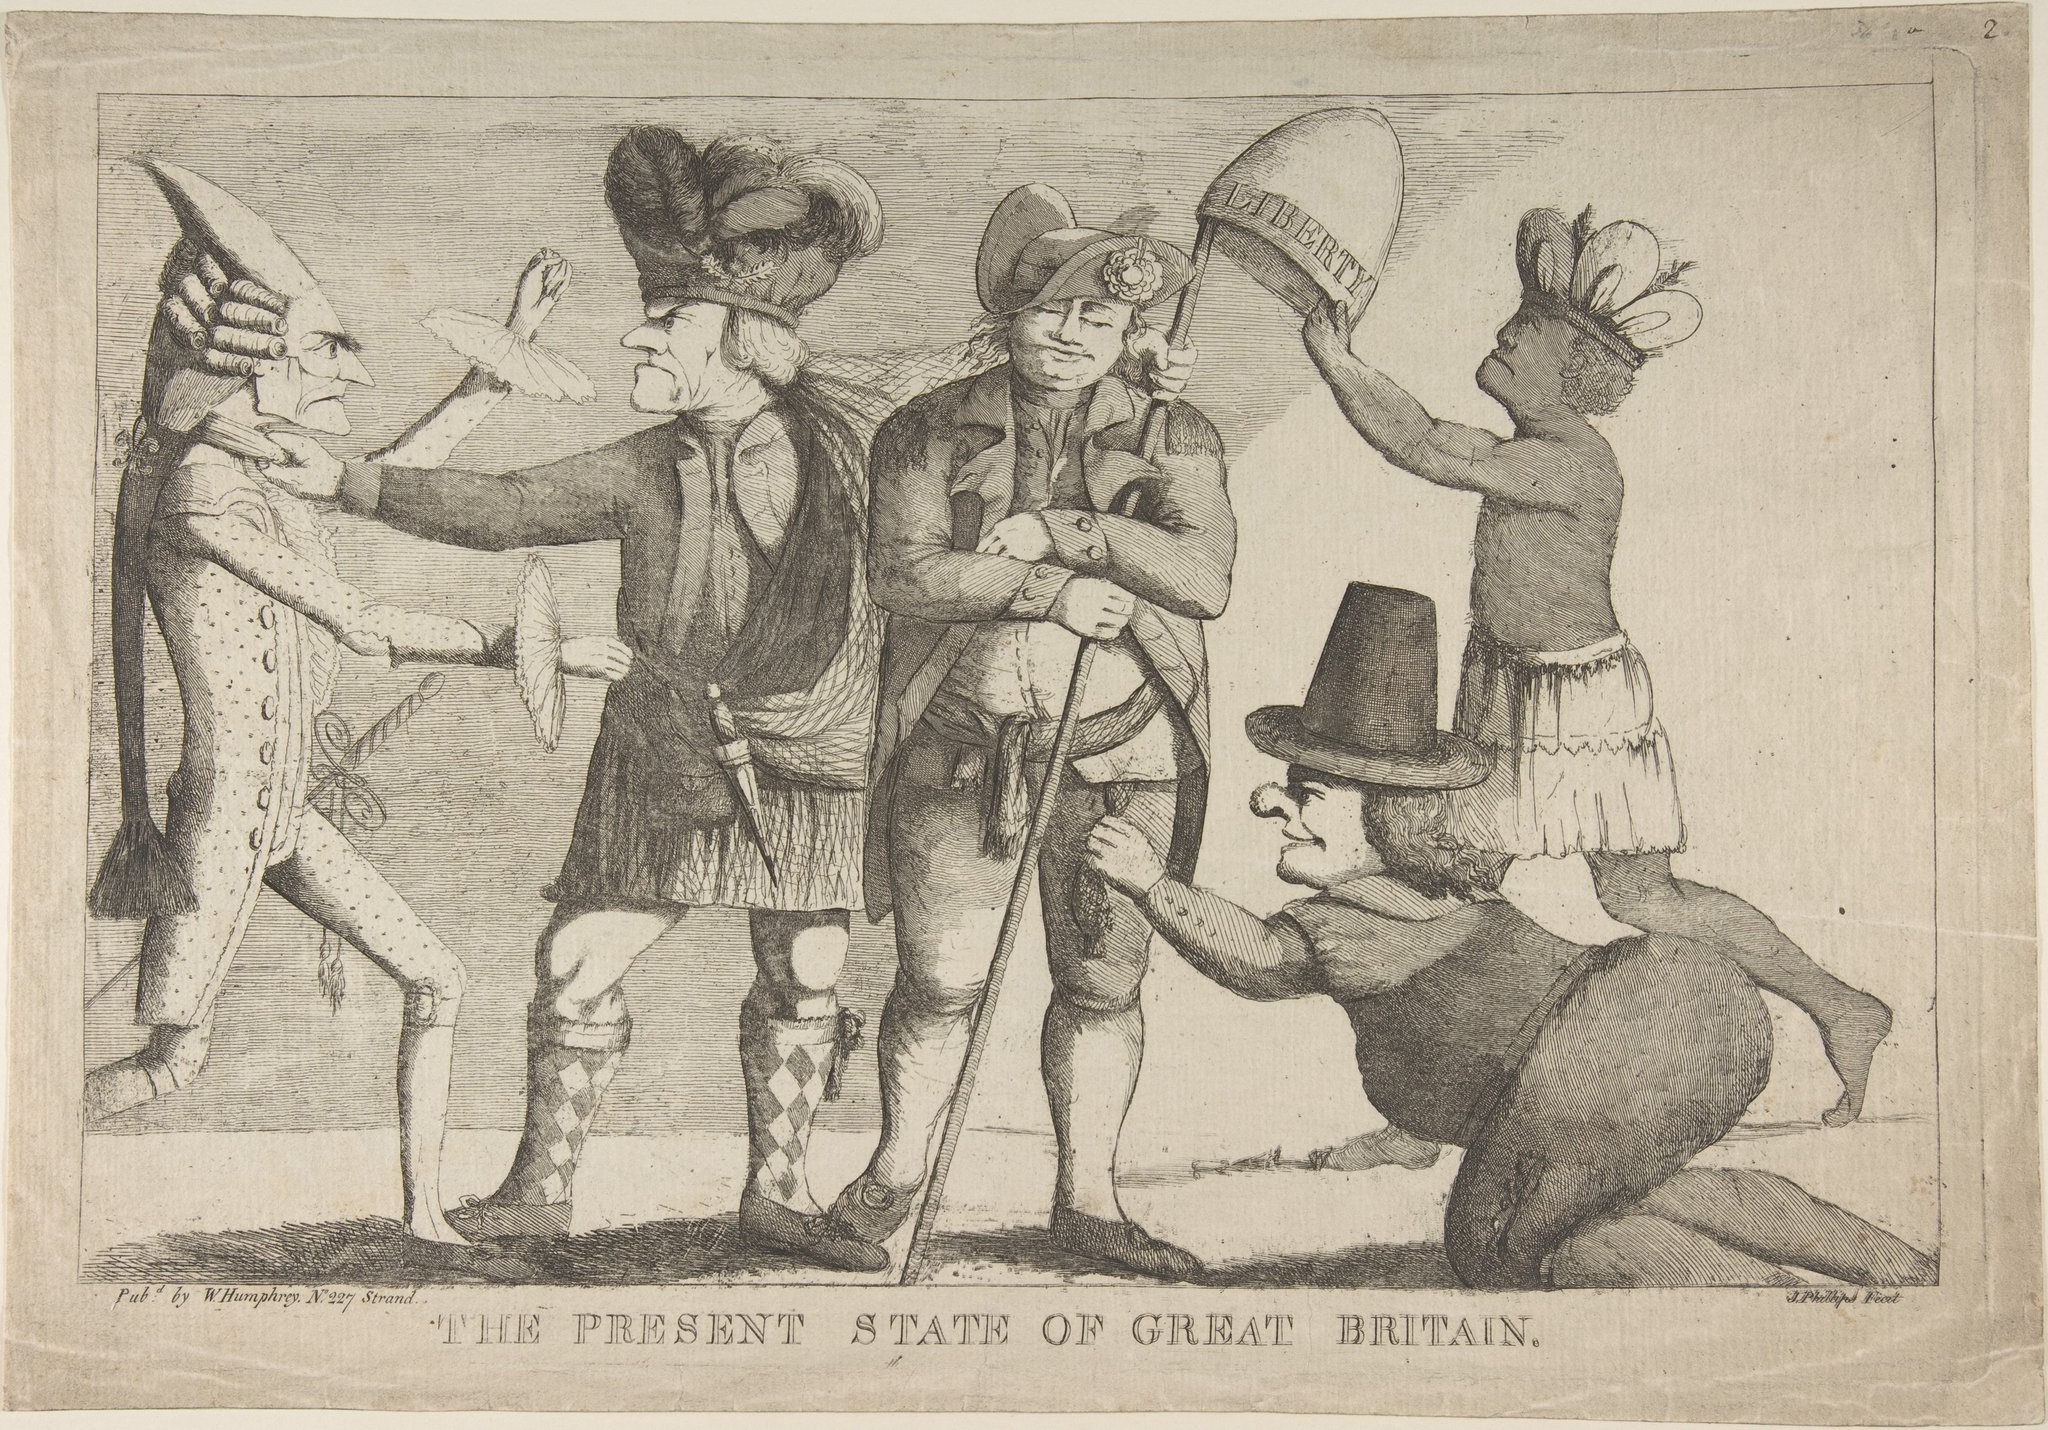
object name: print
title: The Present State of Great Britain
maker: james phillips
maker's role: artist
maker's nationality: british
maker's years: 1786-1809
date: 1779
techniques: etching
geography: london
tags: satire,american revolution,men,allegory,politics